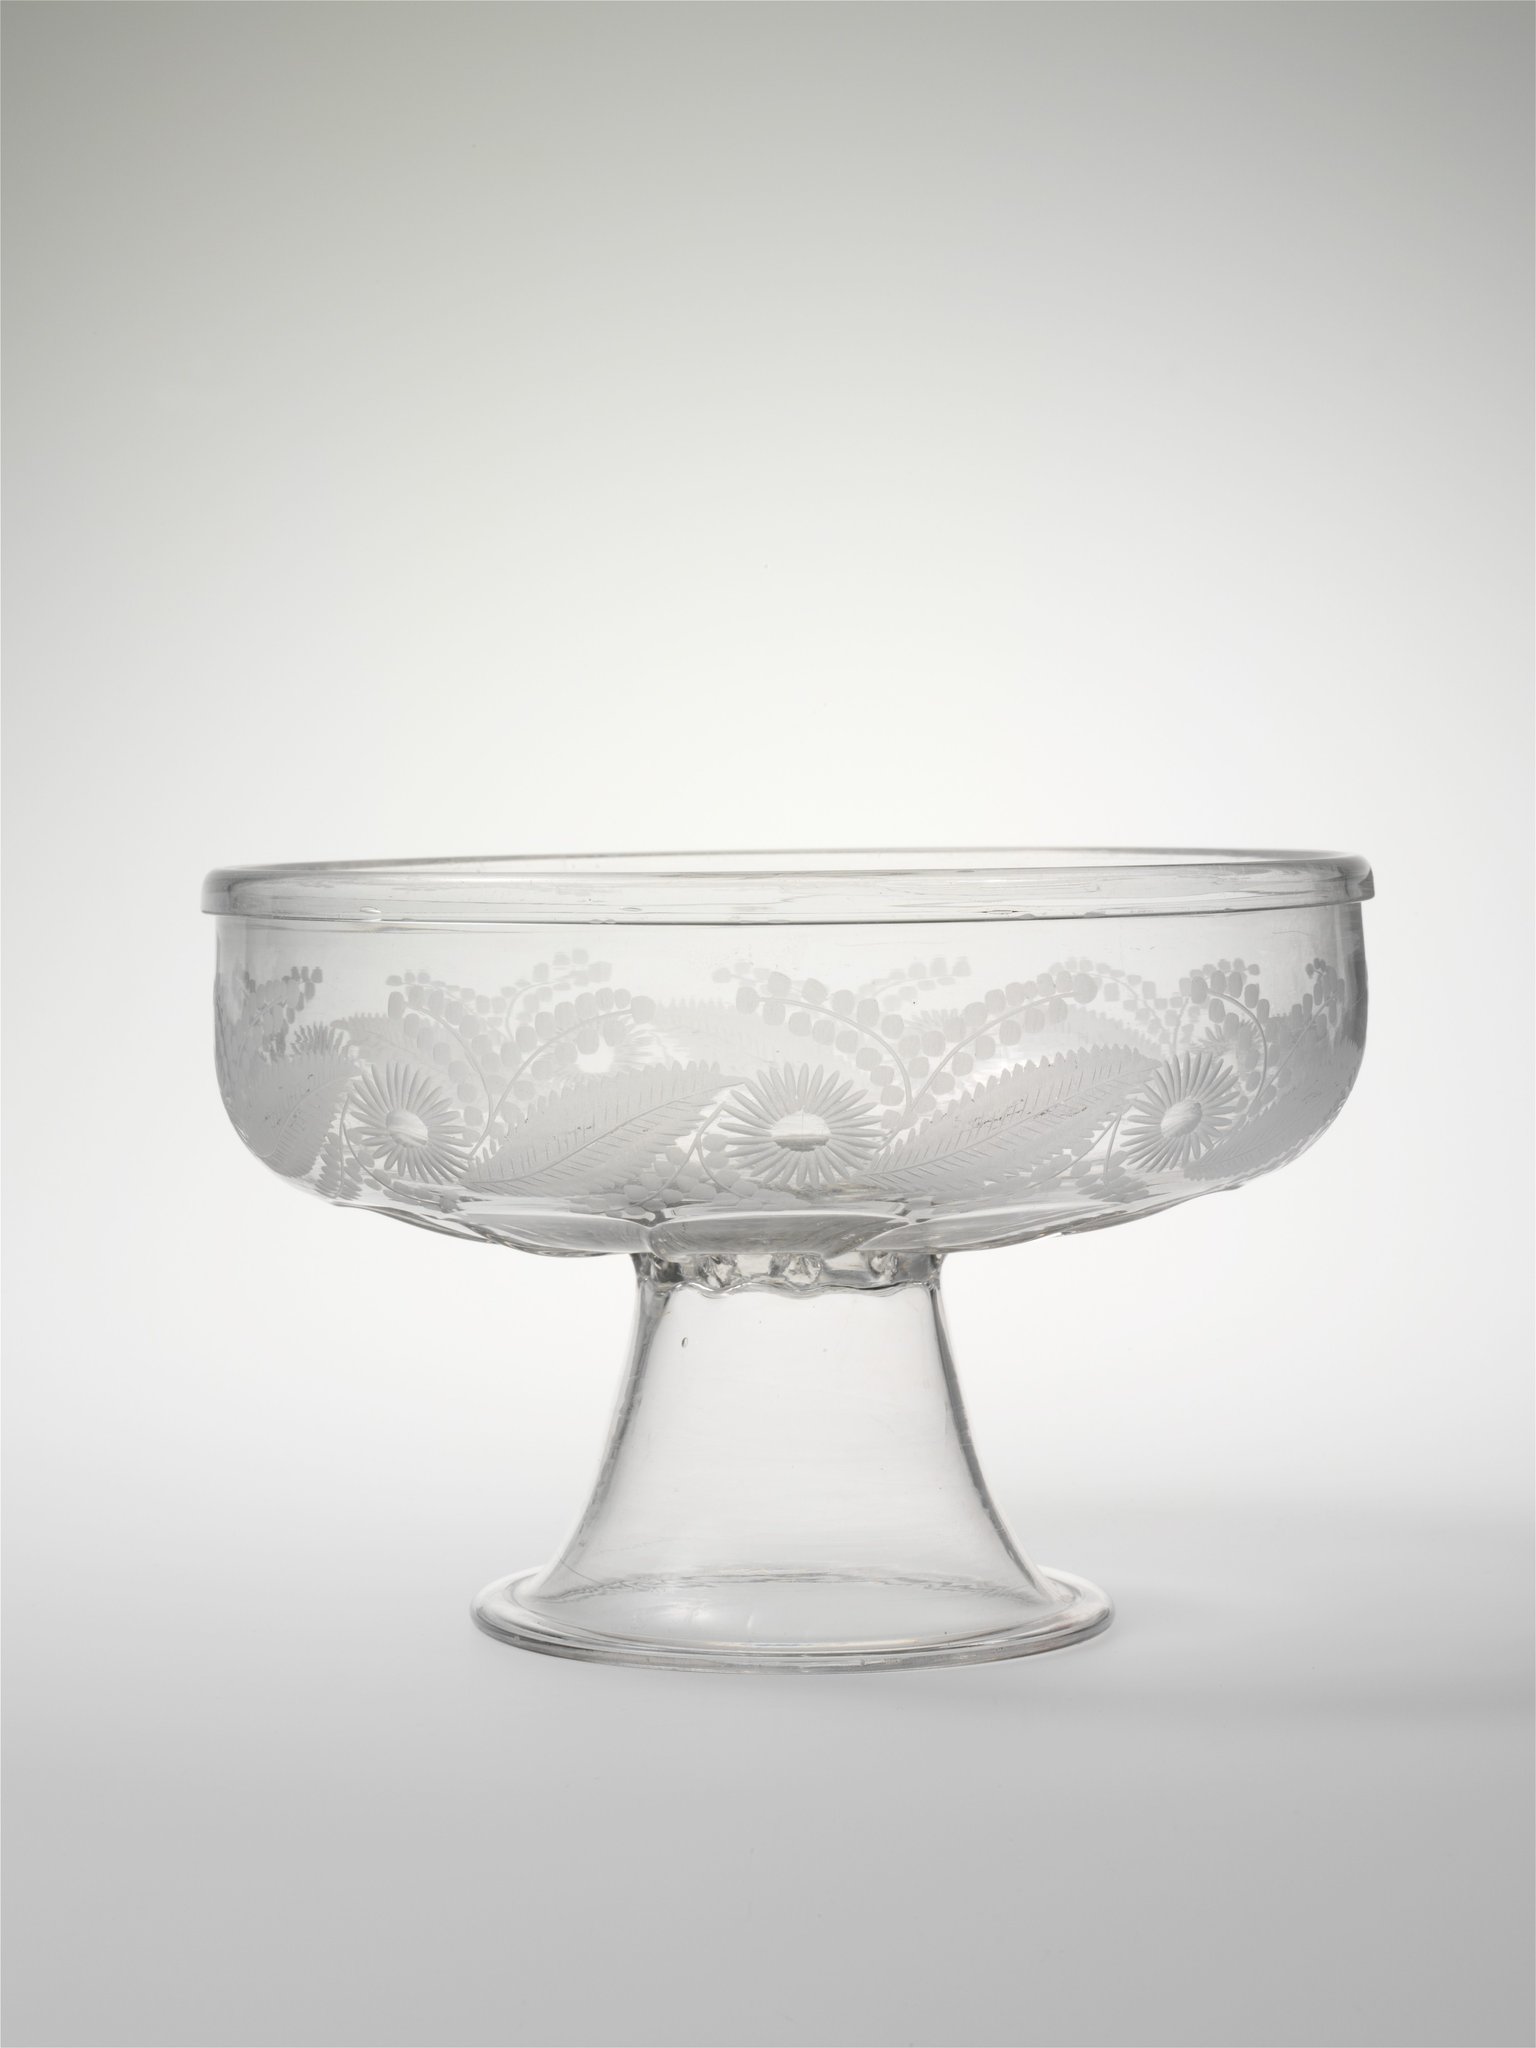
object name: compote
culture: american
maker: benjamin bakewell & co.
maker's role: maker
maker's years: 1809-1813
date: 1810-1825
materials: glass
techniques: glassblowing, engraving, molding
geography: united states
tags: flowers